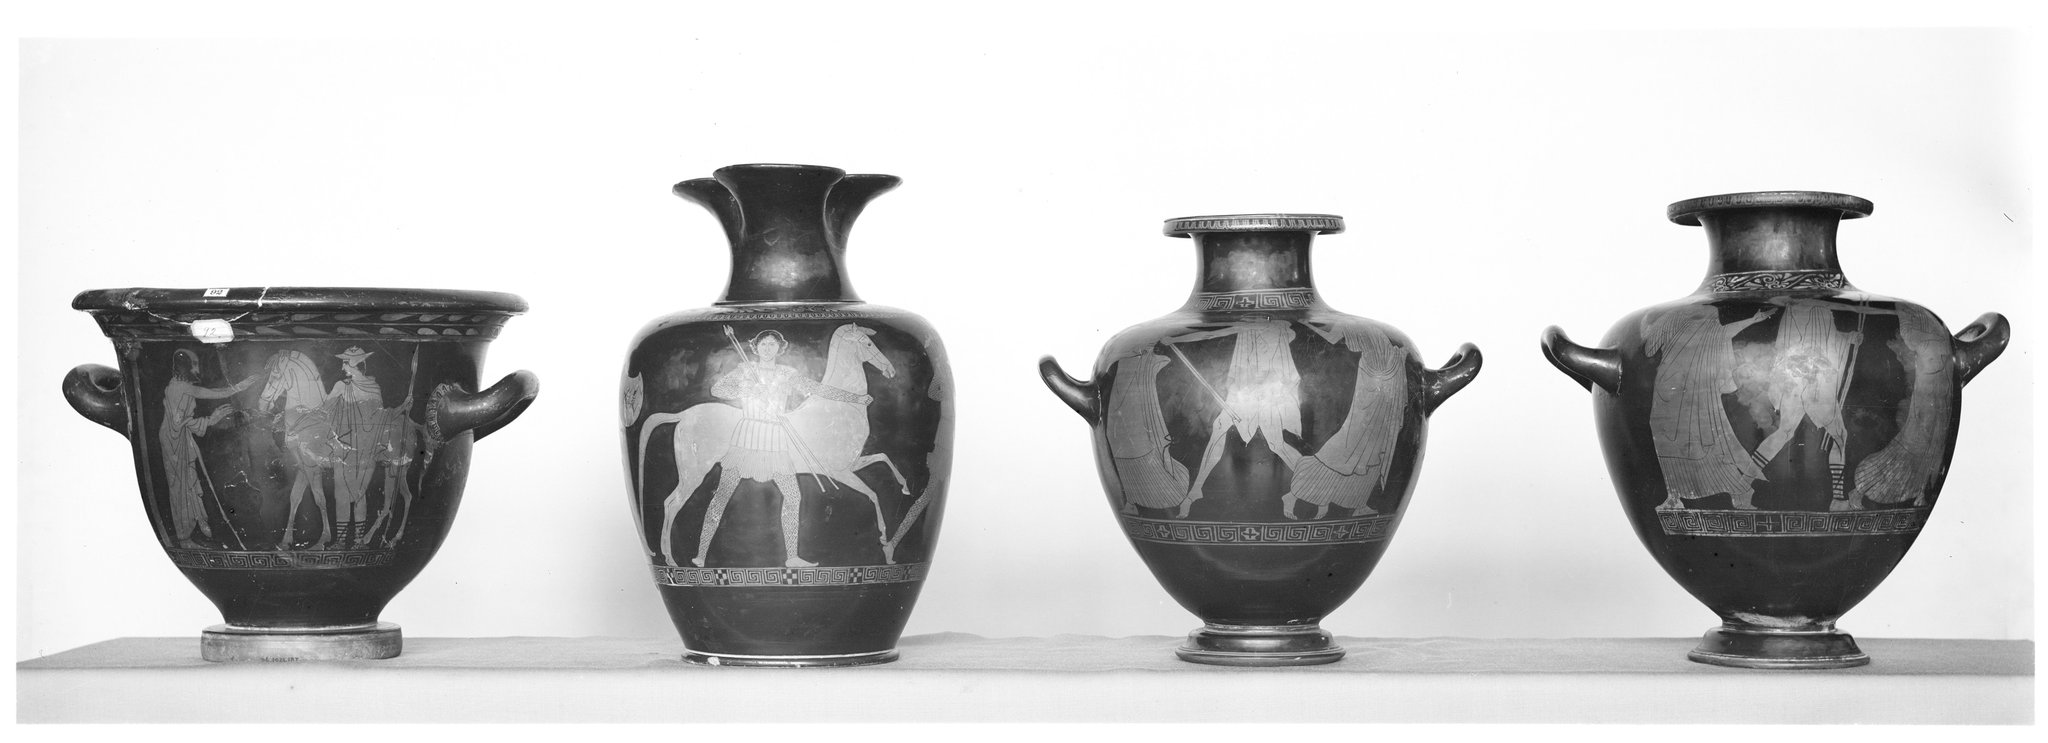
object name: bell krater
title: Terracotta bell-krater (bowl for mixing wine and water)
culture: greek, attic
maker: polydektes painter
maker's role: artist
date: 440 BCE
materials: terracotta